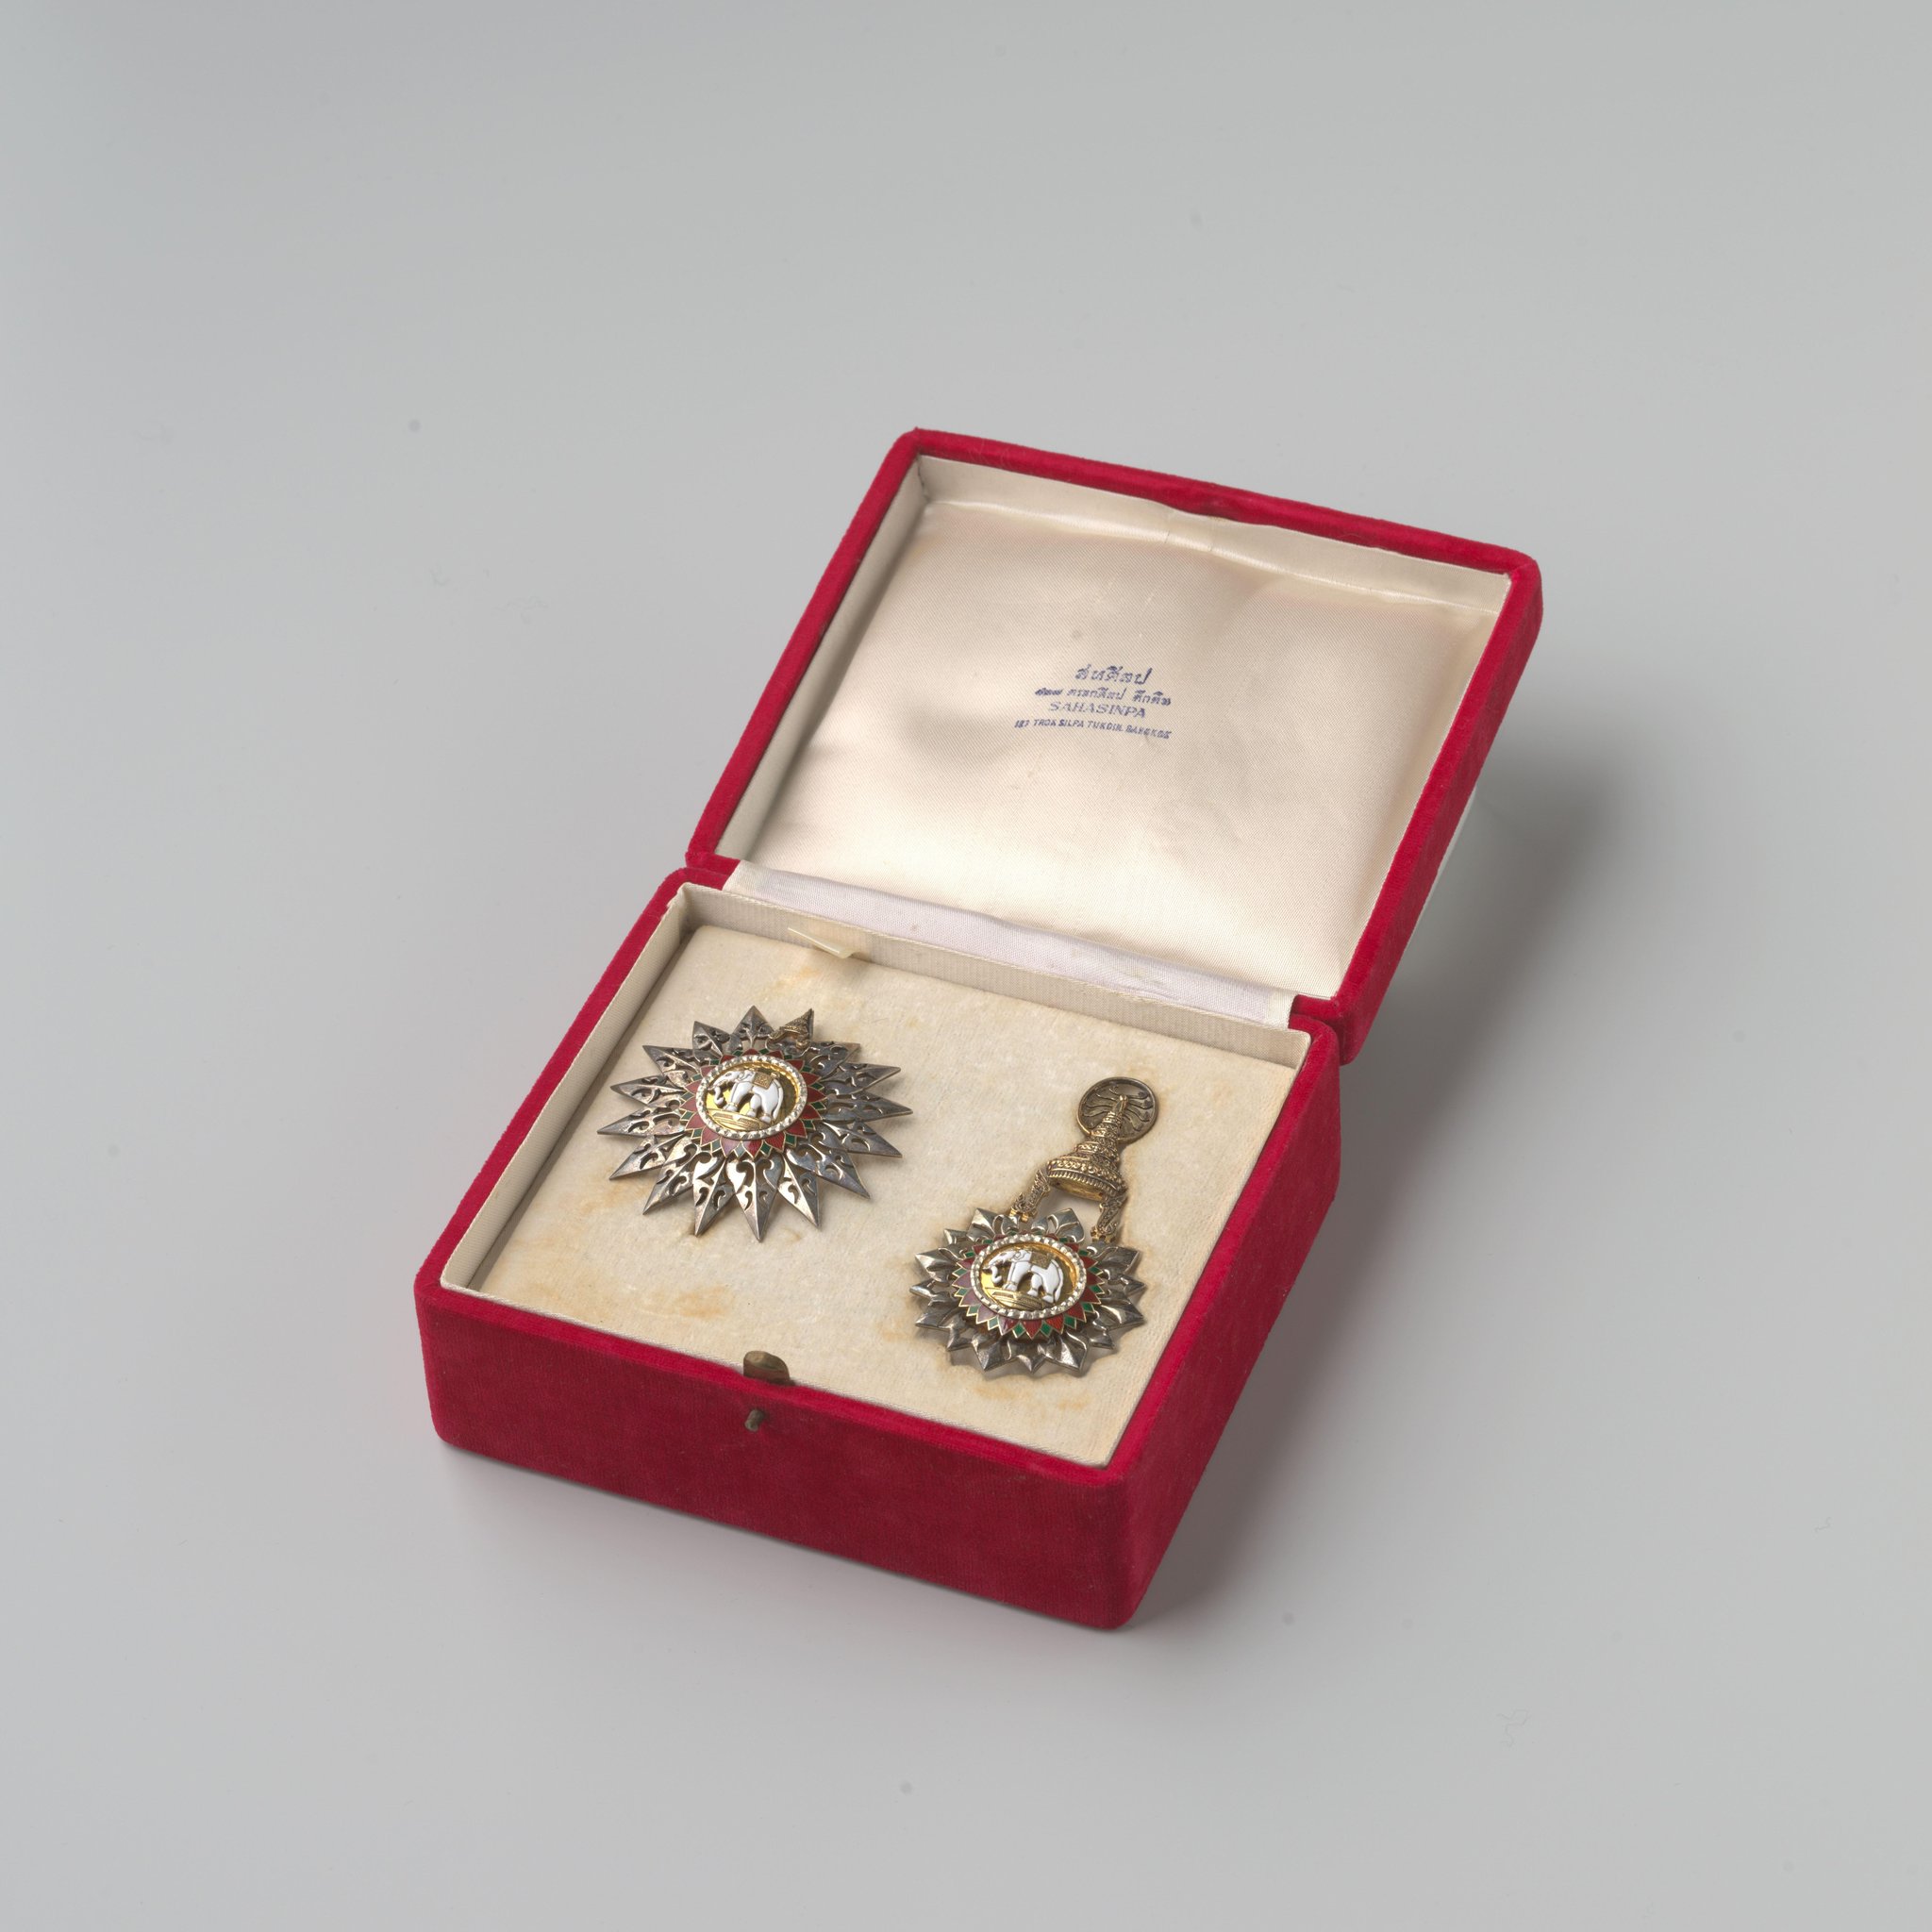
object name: blotter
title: Thaise ridderorde (Orde van de Witte Olifant), ontvangen door Willem Drees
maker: Anonymous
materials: silver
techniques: gilding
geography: bangkok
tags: amsterdam, the hague, willem drees, netherlands, thailand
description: Het draagteken heeft een bloemvormige vorm met acht grote en daartussen acht kleinere punten. Het medaillon toont een gouden, wit geemailleerde, naar rechts gekeerde olifant met draagzadel die op een piedestal staat, op gouden ondergrond, omringd met gebrillianteerd zilver, waaromheen een bloemenkrans van afwisselend rood en groen geemailleerde punten; de keerzijde toont in het medaillon in rood letterachtige figuren en is verder identiek aan de voorzijde. Het draagteken hangt met twee vleugelachtige versieringen aan een pagode-achtige structuur (een kroon?) die wordt bekroond met een met slangachtige vormen gevuld ovaal.